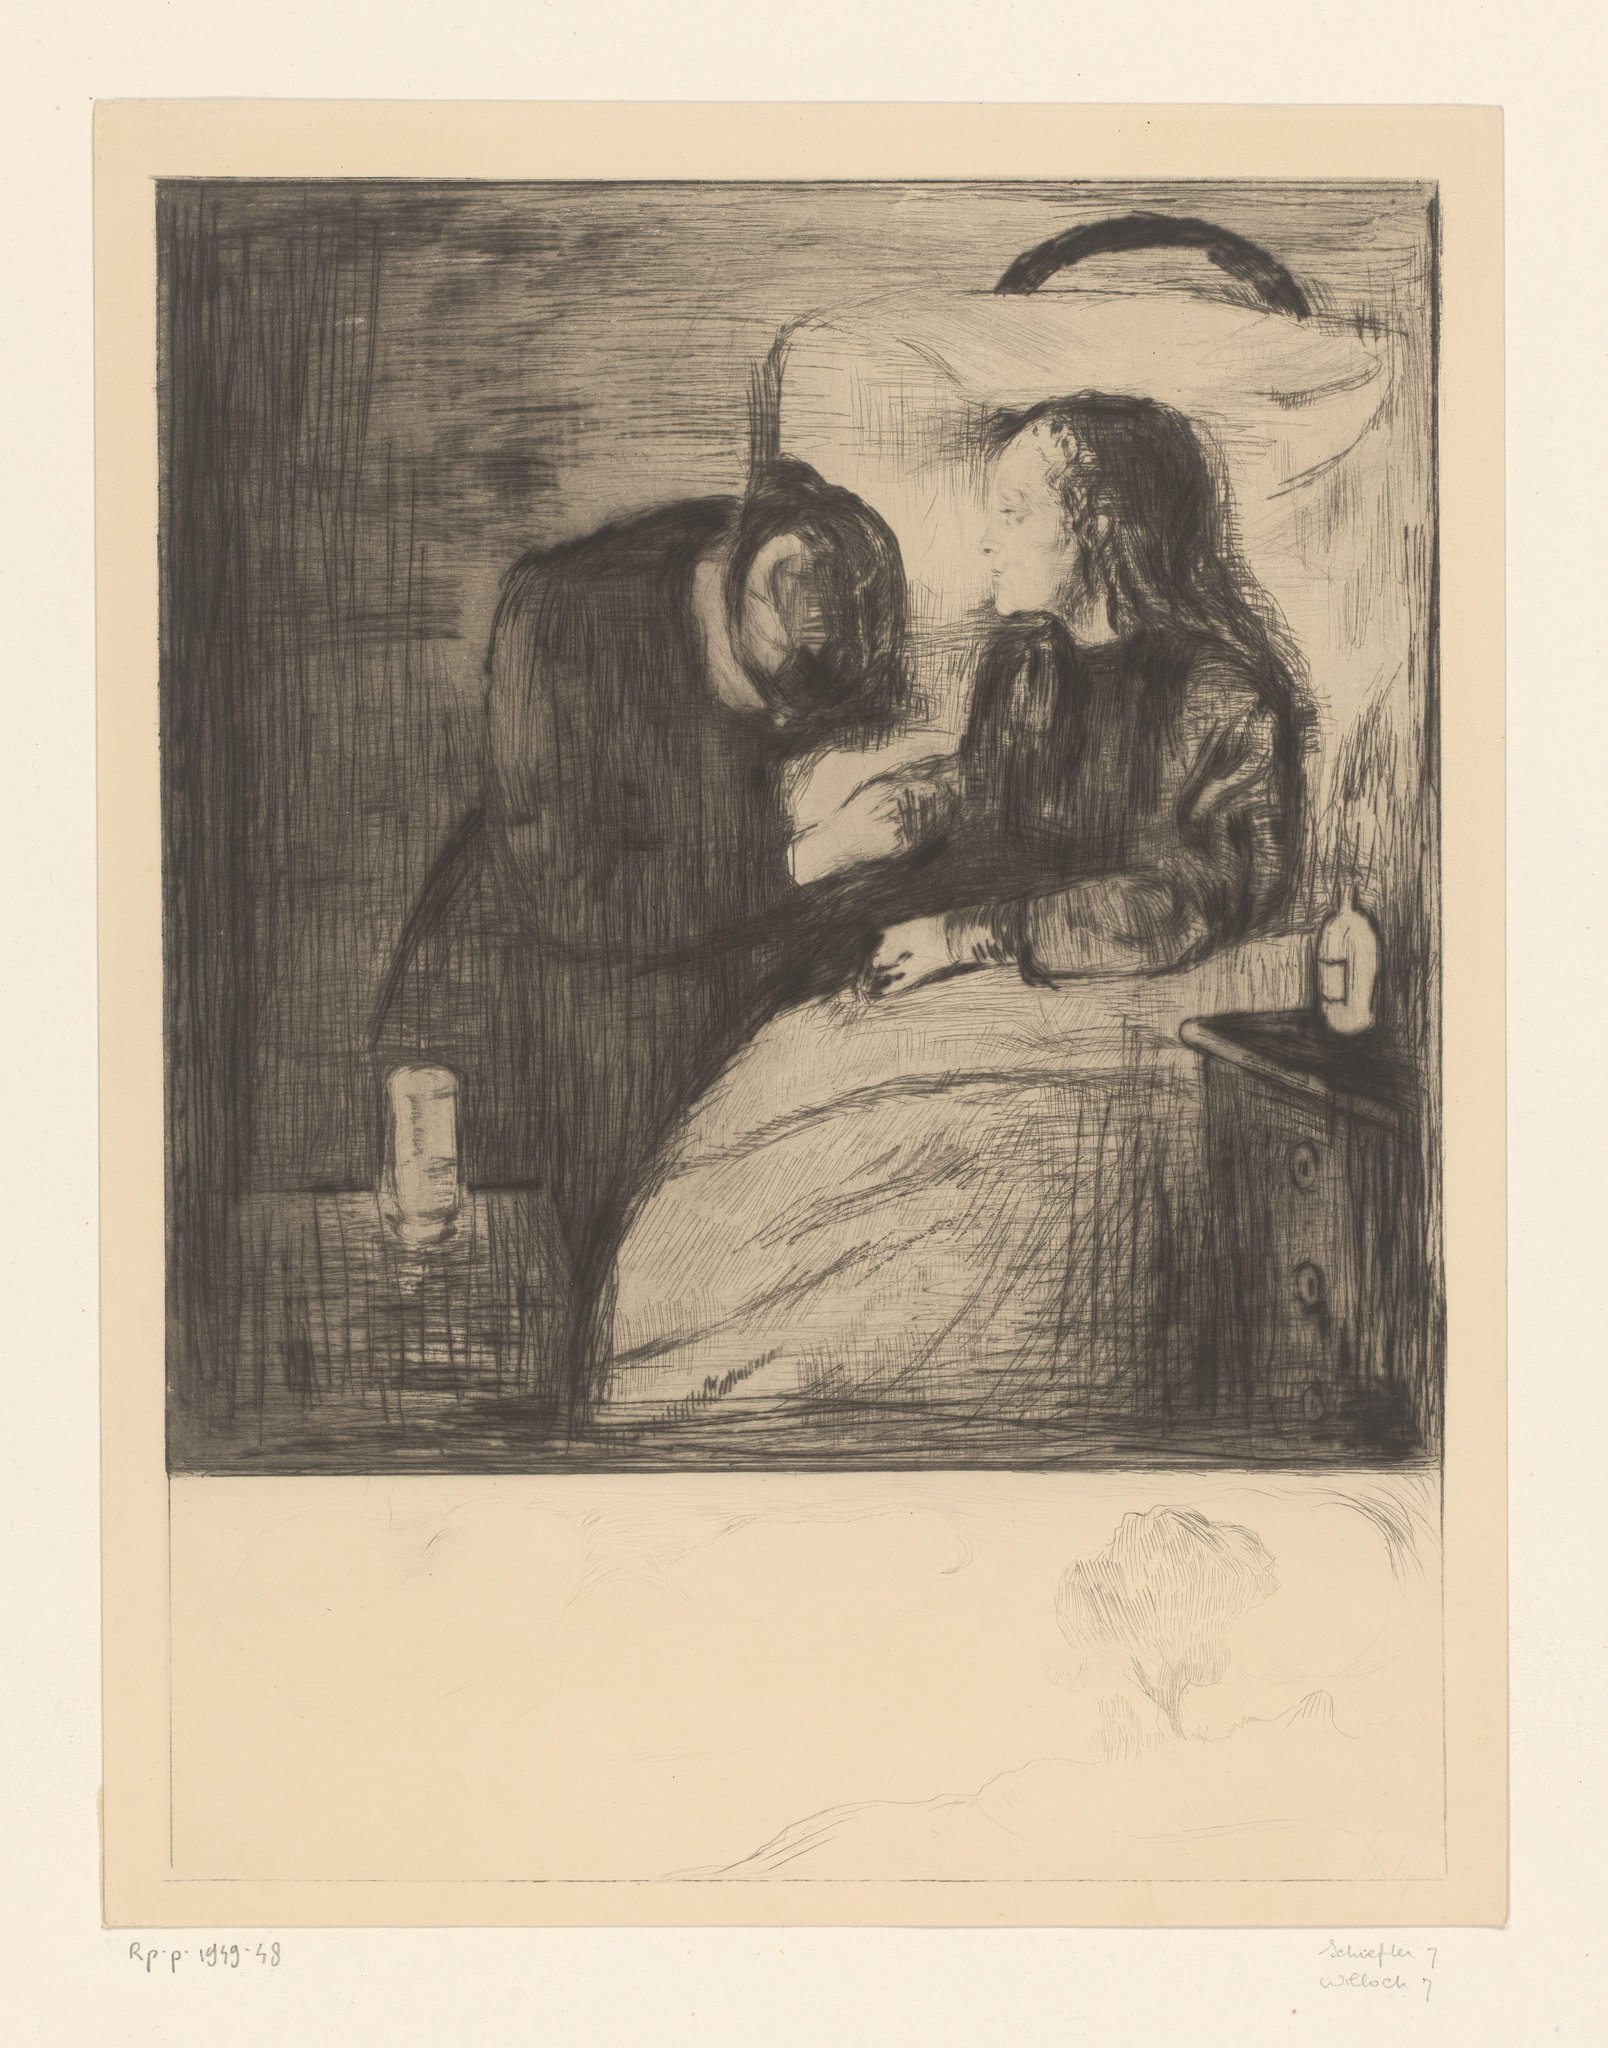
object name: print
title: Het zieke kind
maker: edvard munch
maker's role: print maker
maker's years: 1863-1944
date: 1894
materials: paper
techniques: drypoint, intaglio, roulette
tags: patient, sick person, taking care of children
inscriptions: collector's mark: Lugt 2228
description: Onder de voorstelling een landschap met boom en wolkenlucht.